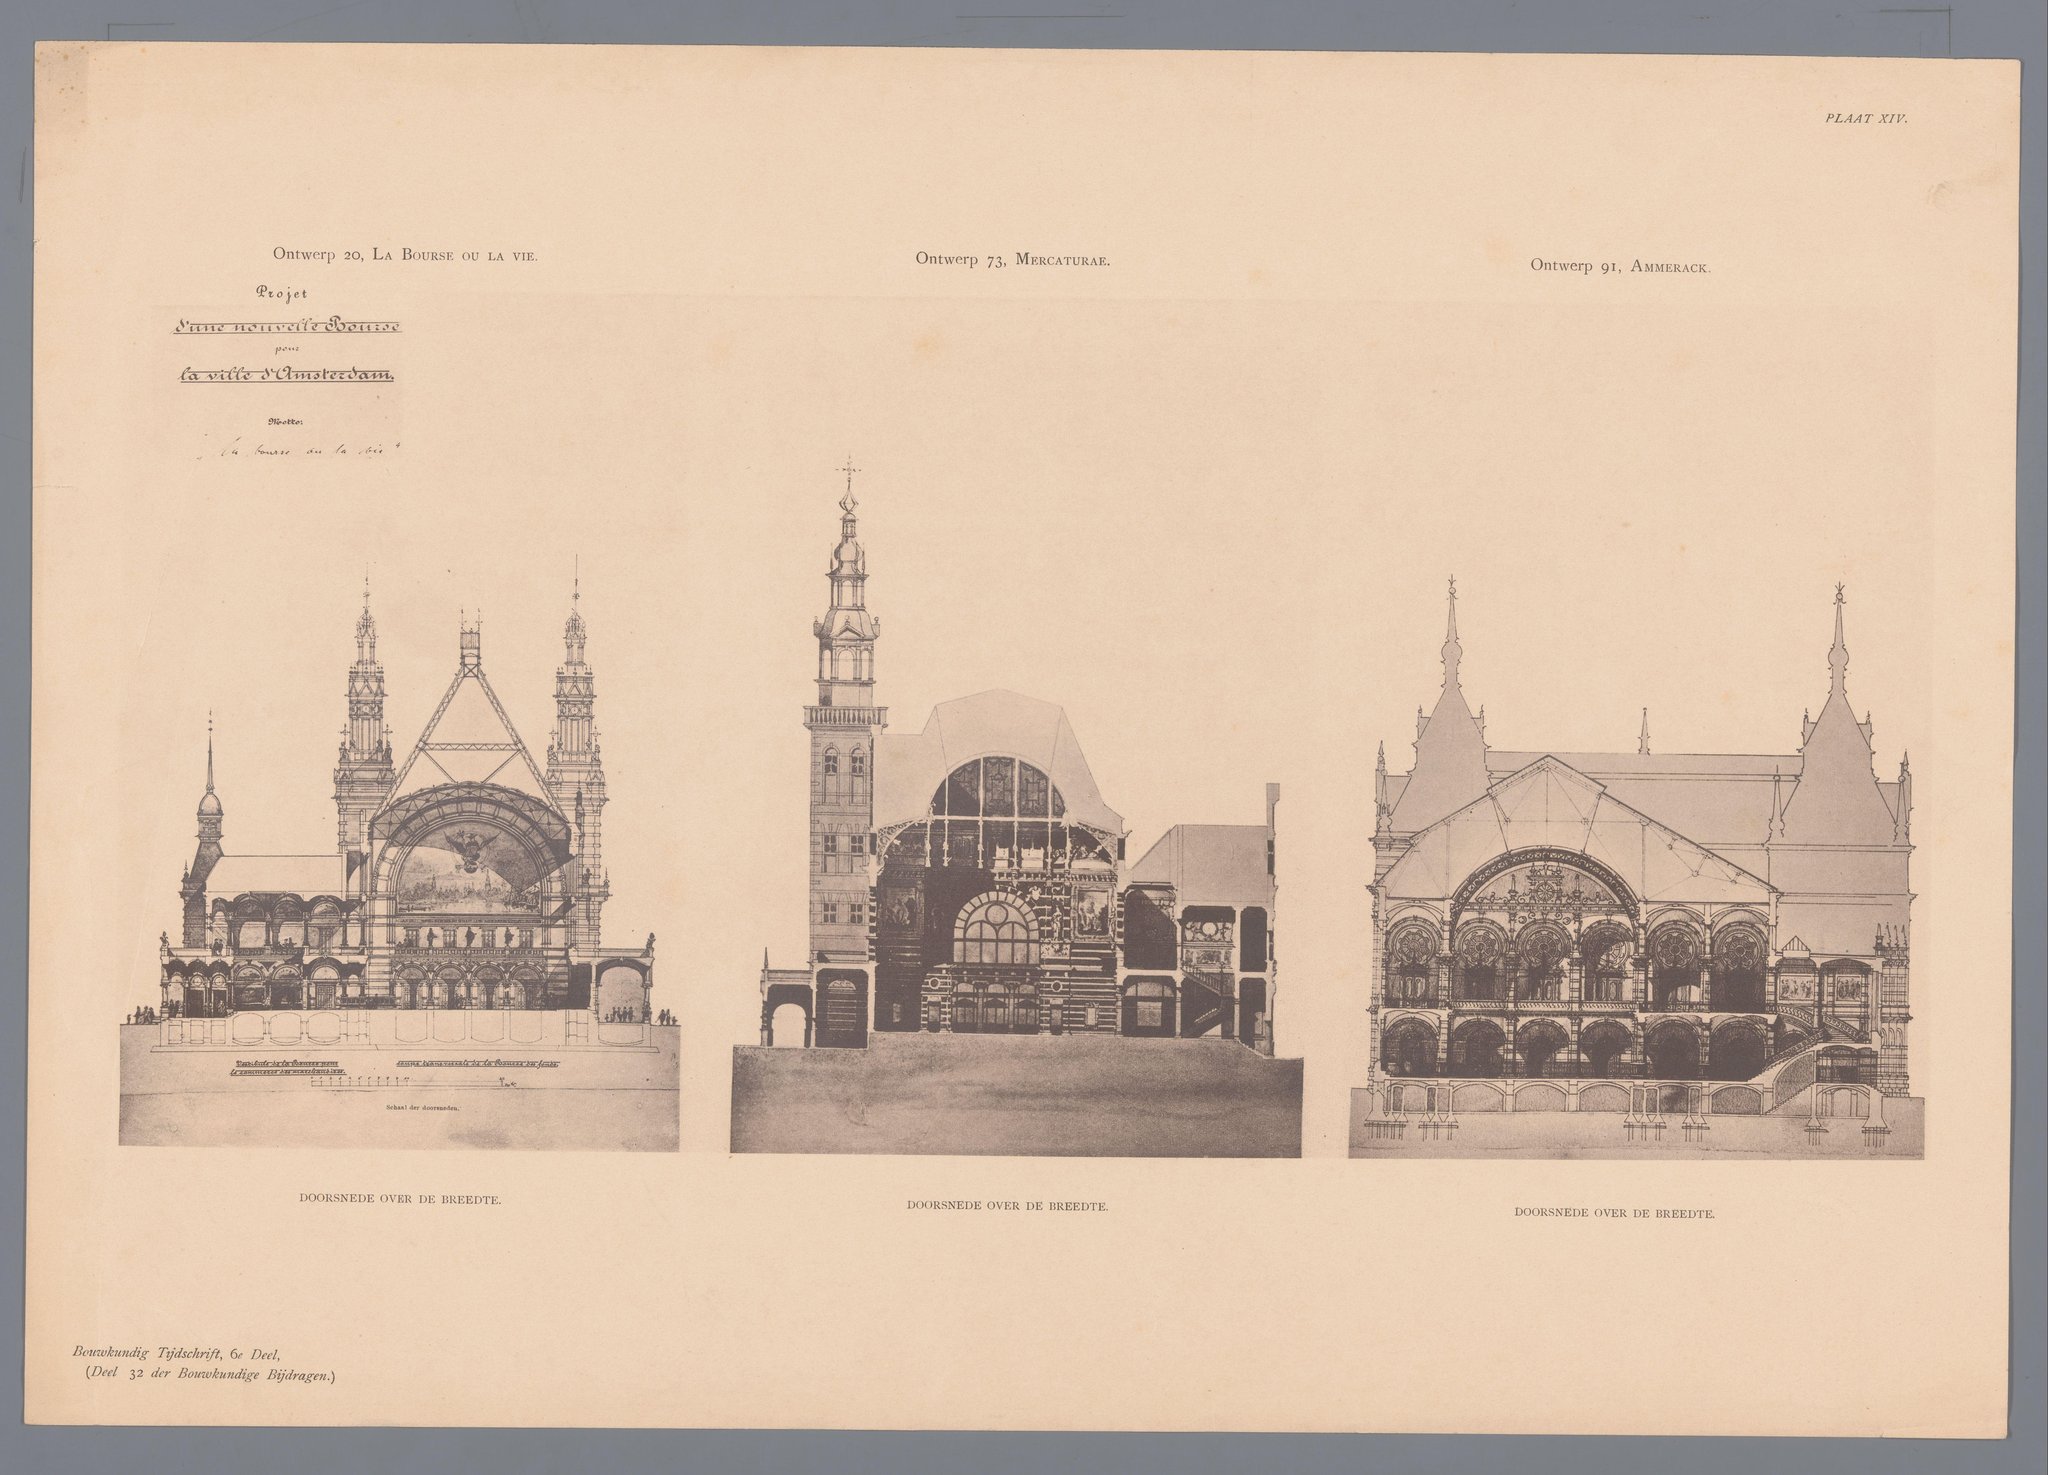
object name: book illustration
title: Ontwerp voor een nieuw beursgebouw in Amsterdam: drie doorsneden van ontwerp 73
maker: Anonymous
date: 1886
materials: paper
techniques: photograph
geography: amsterdam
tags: market-hall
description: Prent uit: Bouwkundig tijdschrift 6, deel 32 der bouwkundige bijdragen (1886), pl. 14.